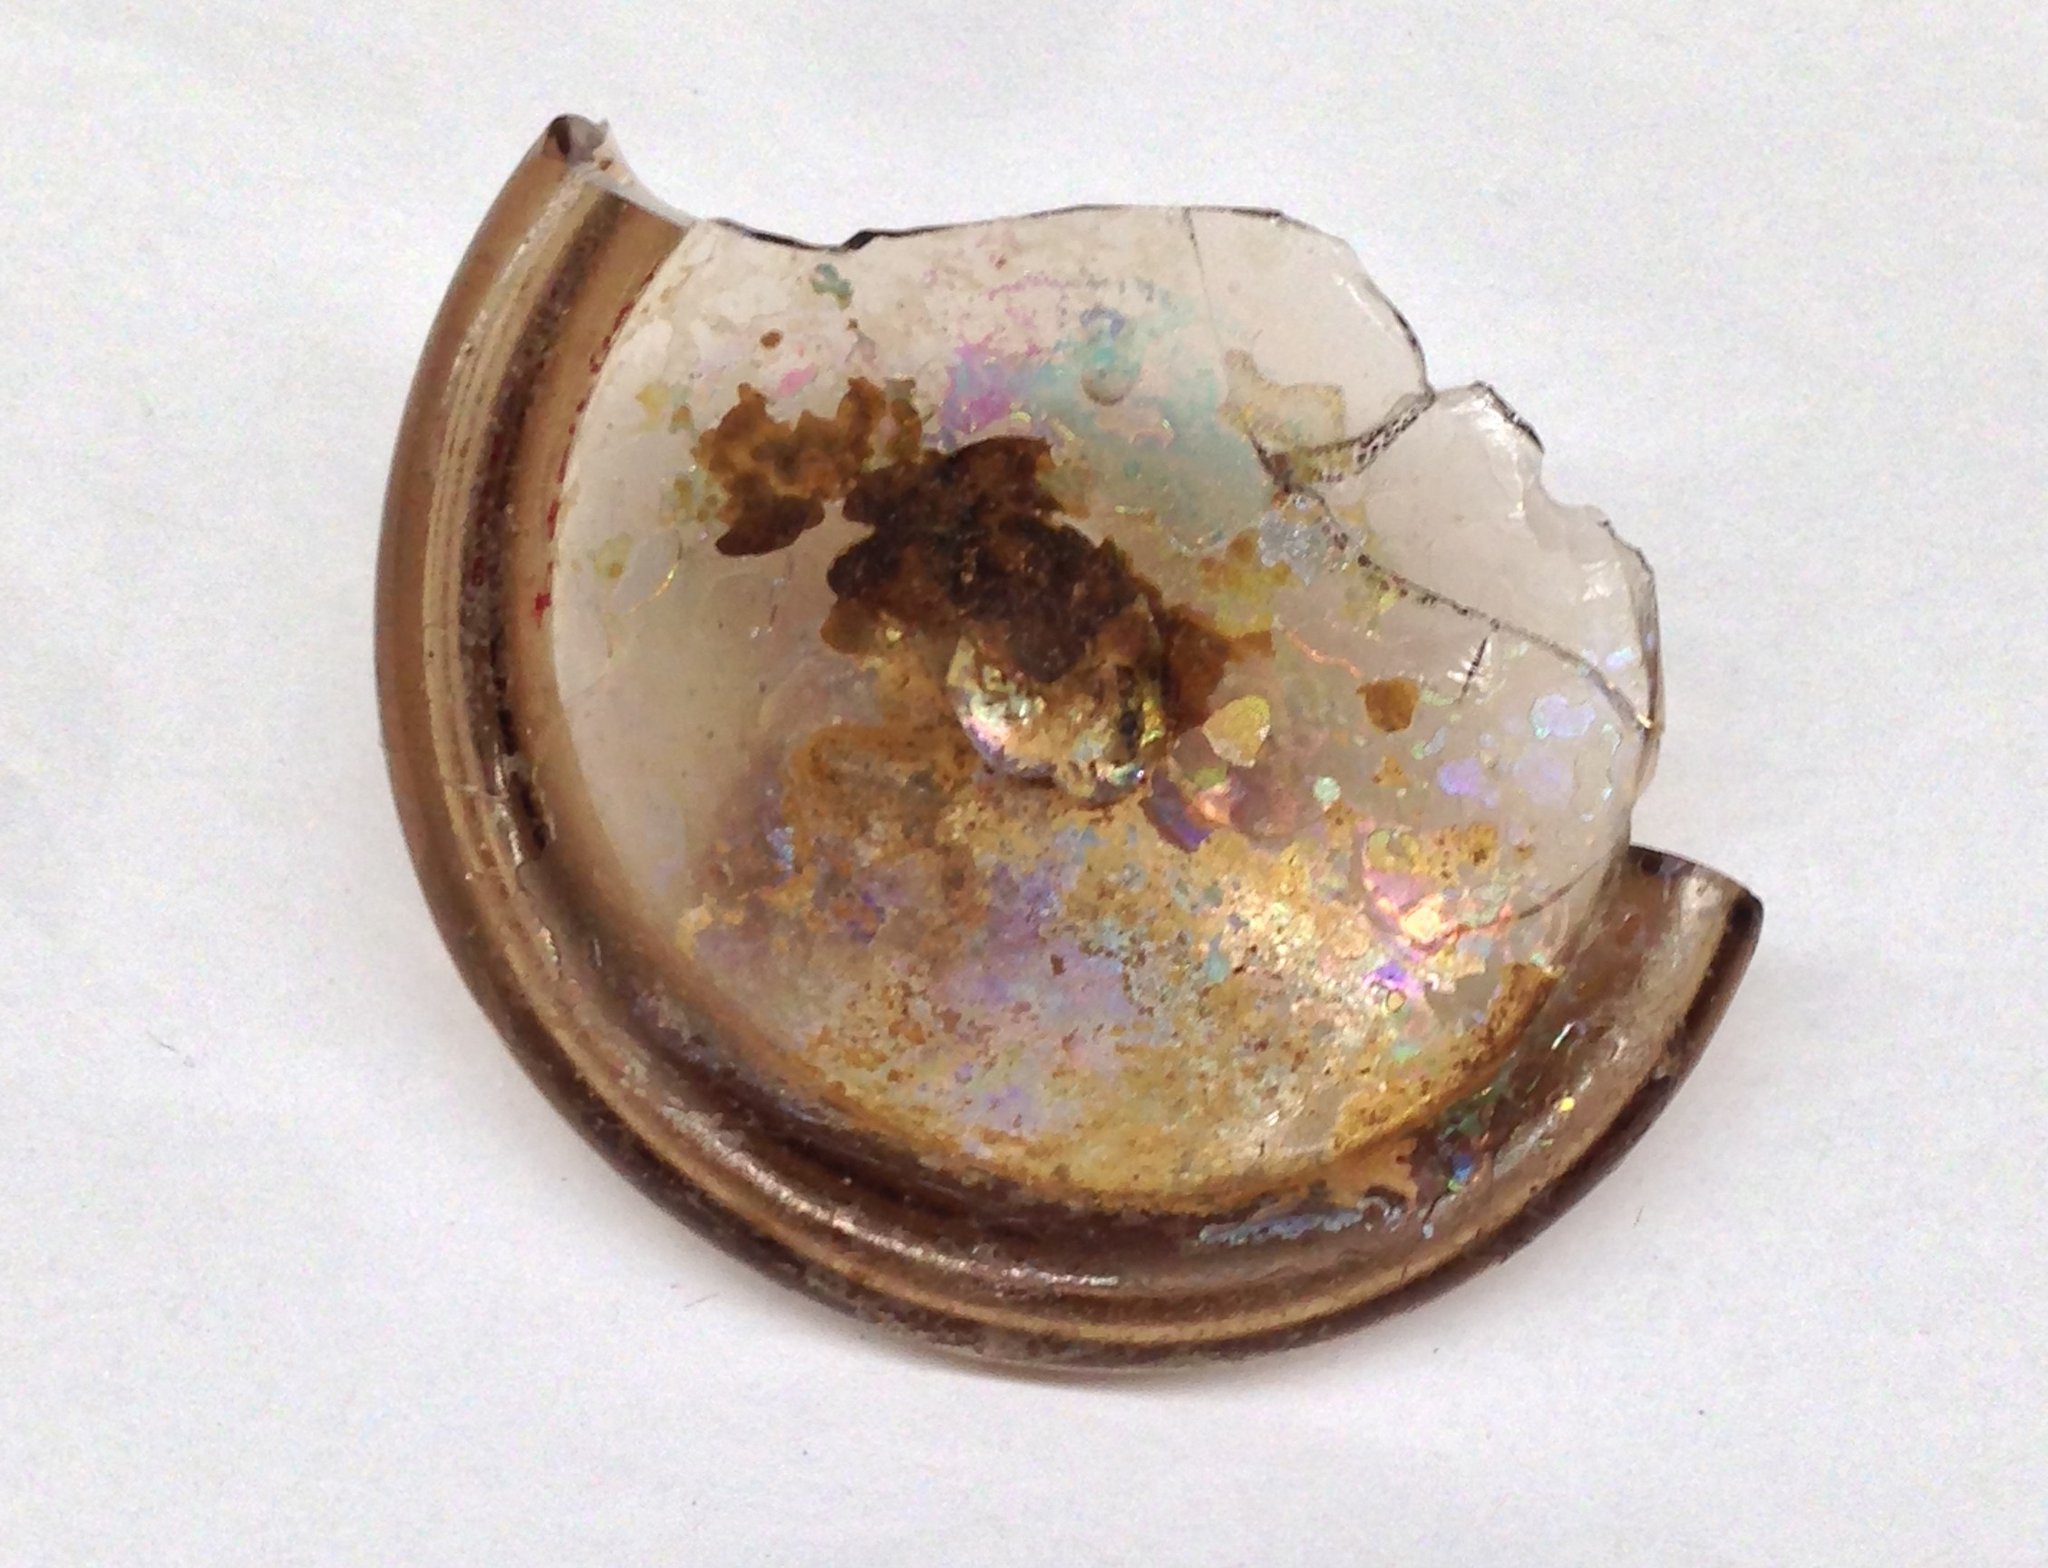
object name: fragment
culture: european or middle eastern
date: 1150-1250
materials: ceramic, glass